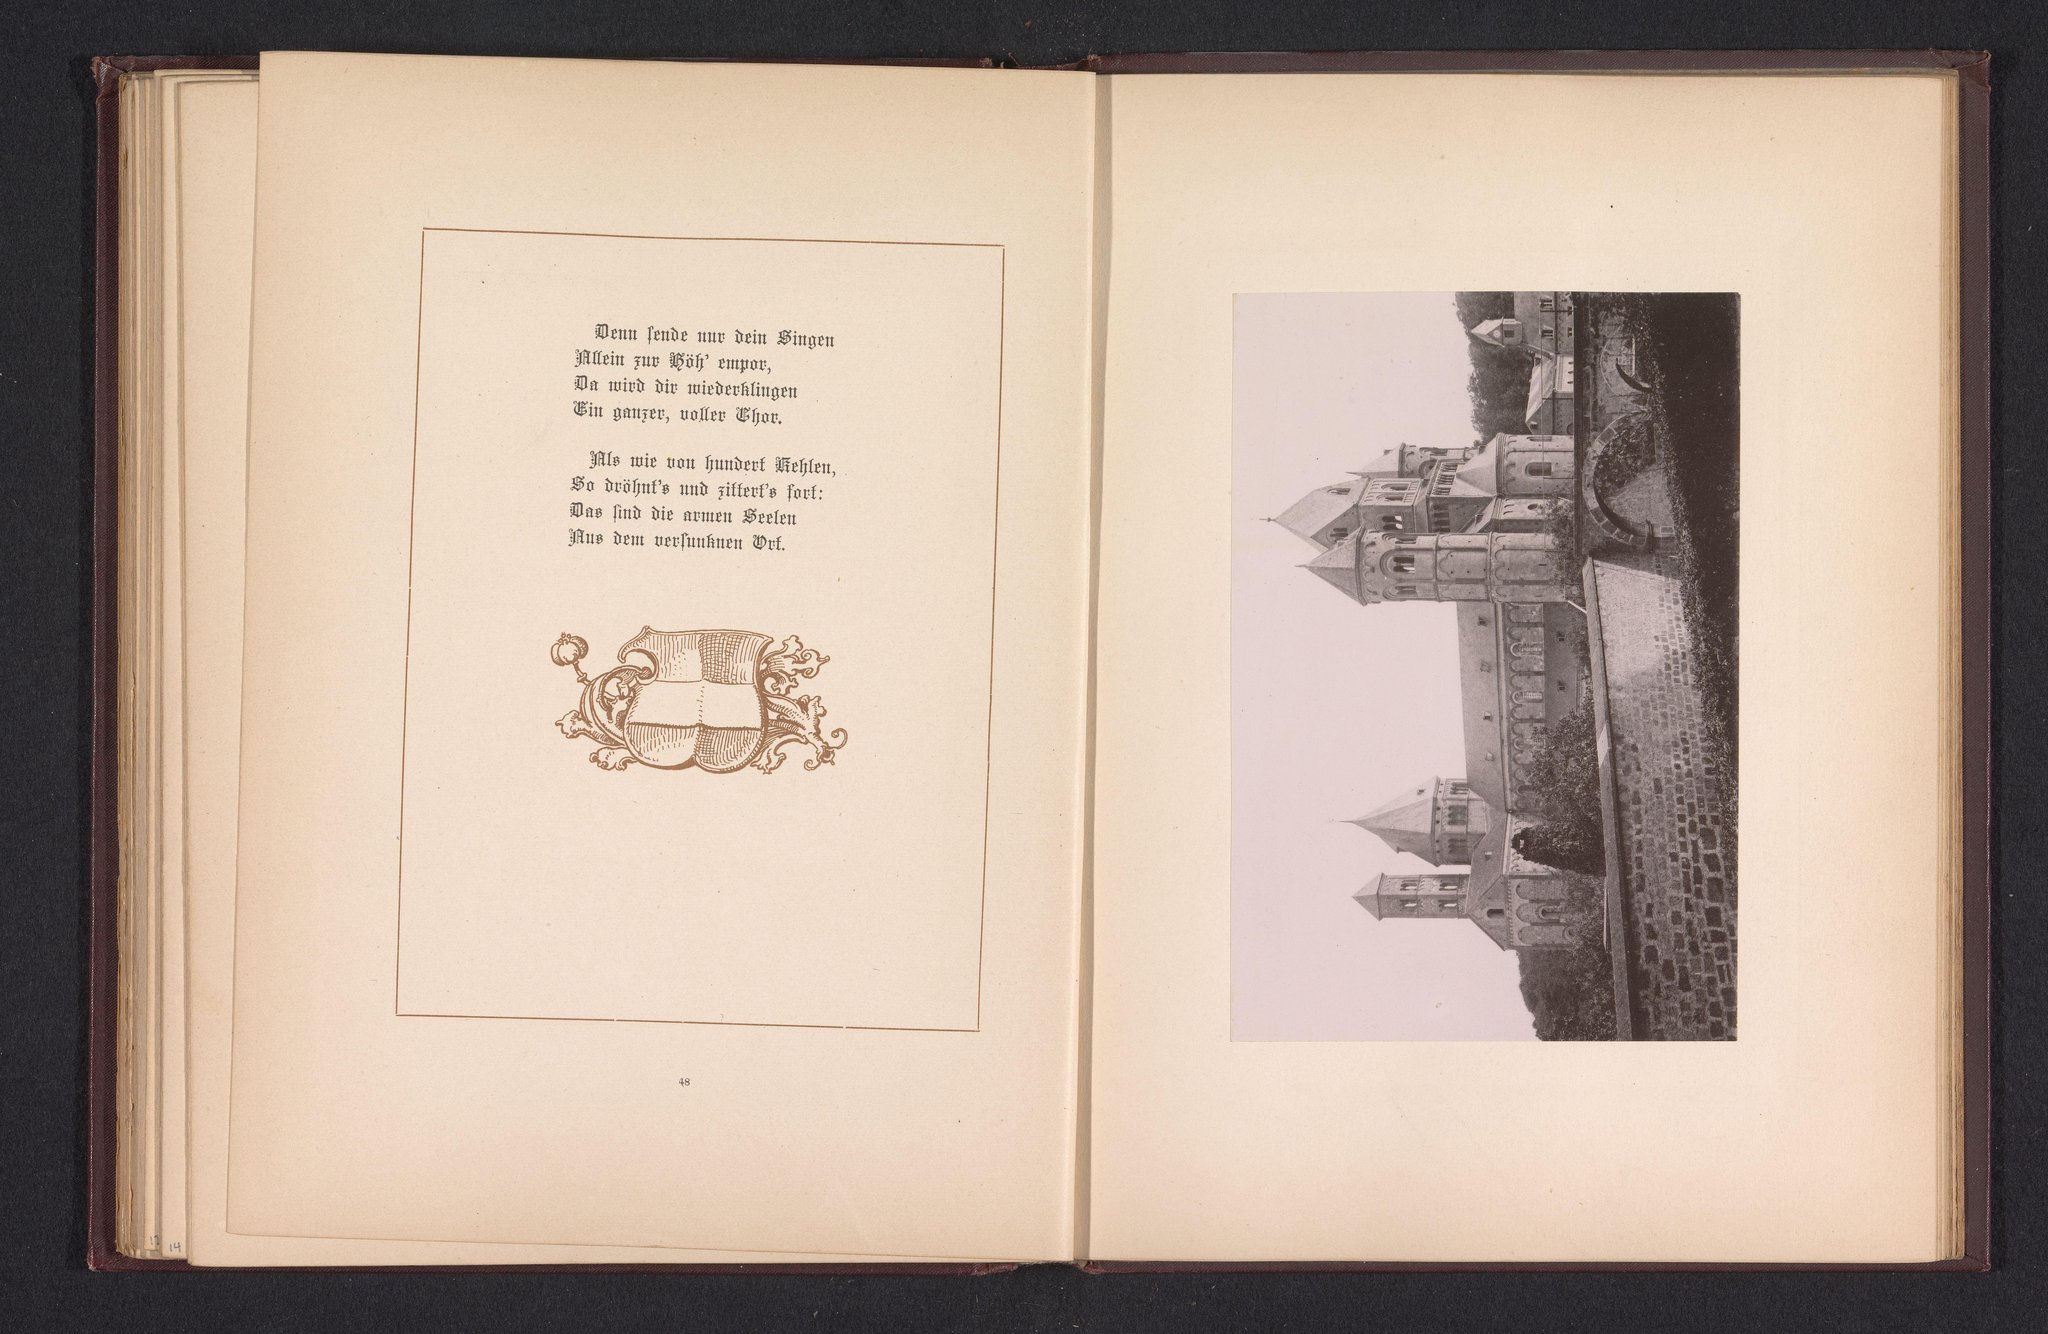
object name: photomechanical print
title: Gezicht op de Abdij van Maria Laach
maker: Anonymous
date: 1881-1891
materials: paper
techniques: photograph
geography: dresden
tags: abbey, monastery, convent ~ roman catholic church, church (exterior)